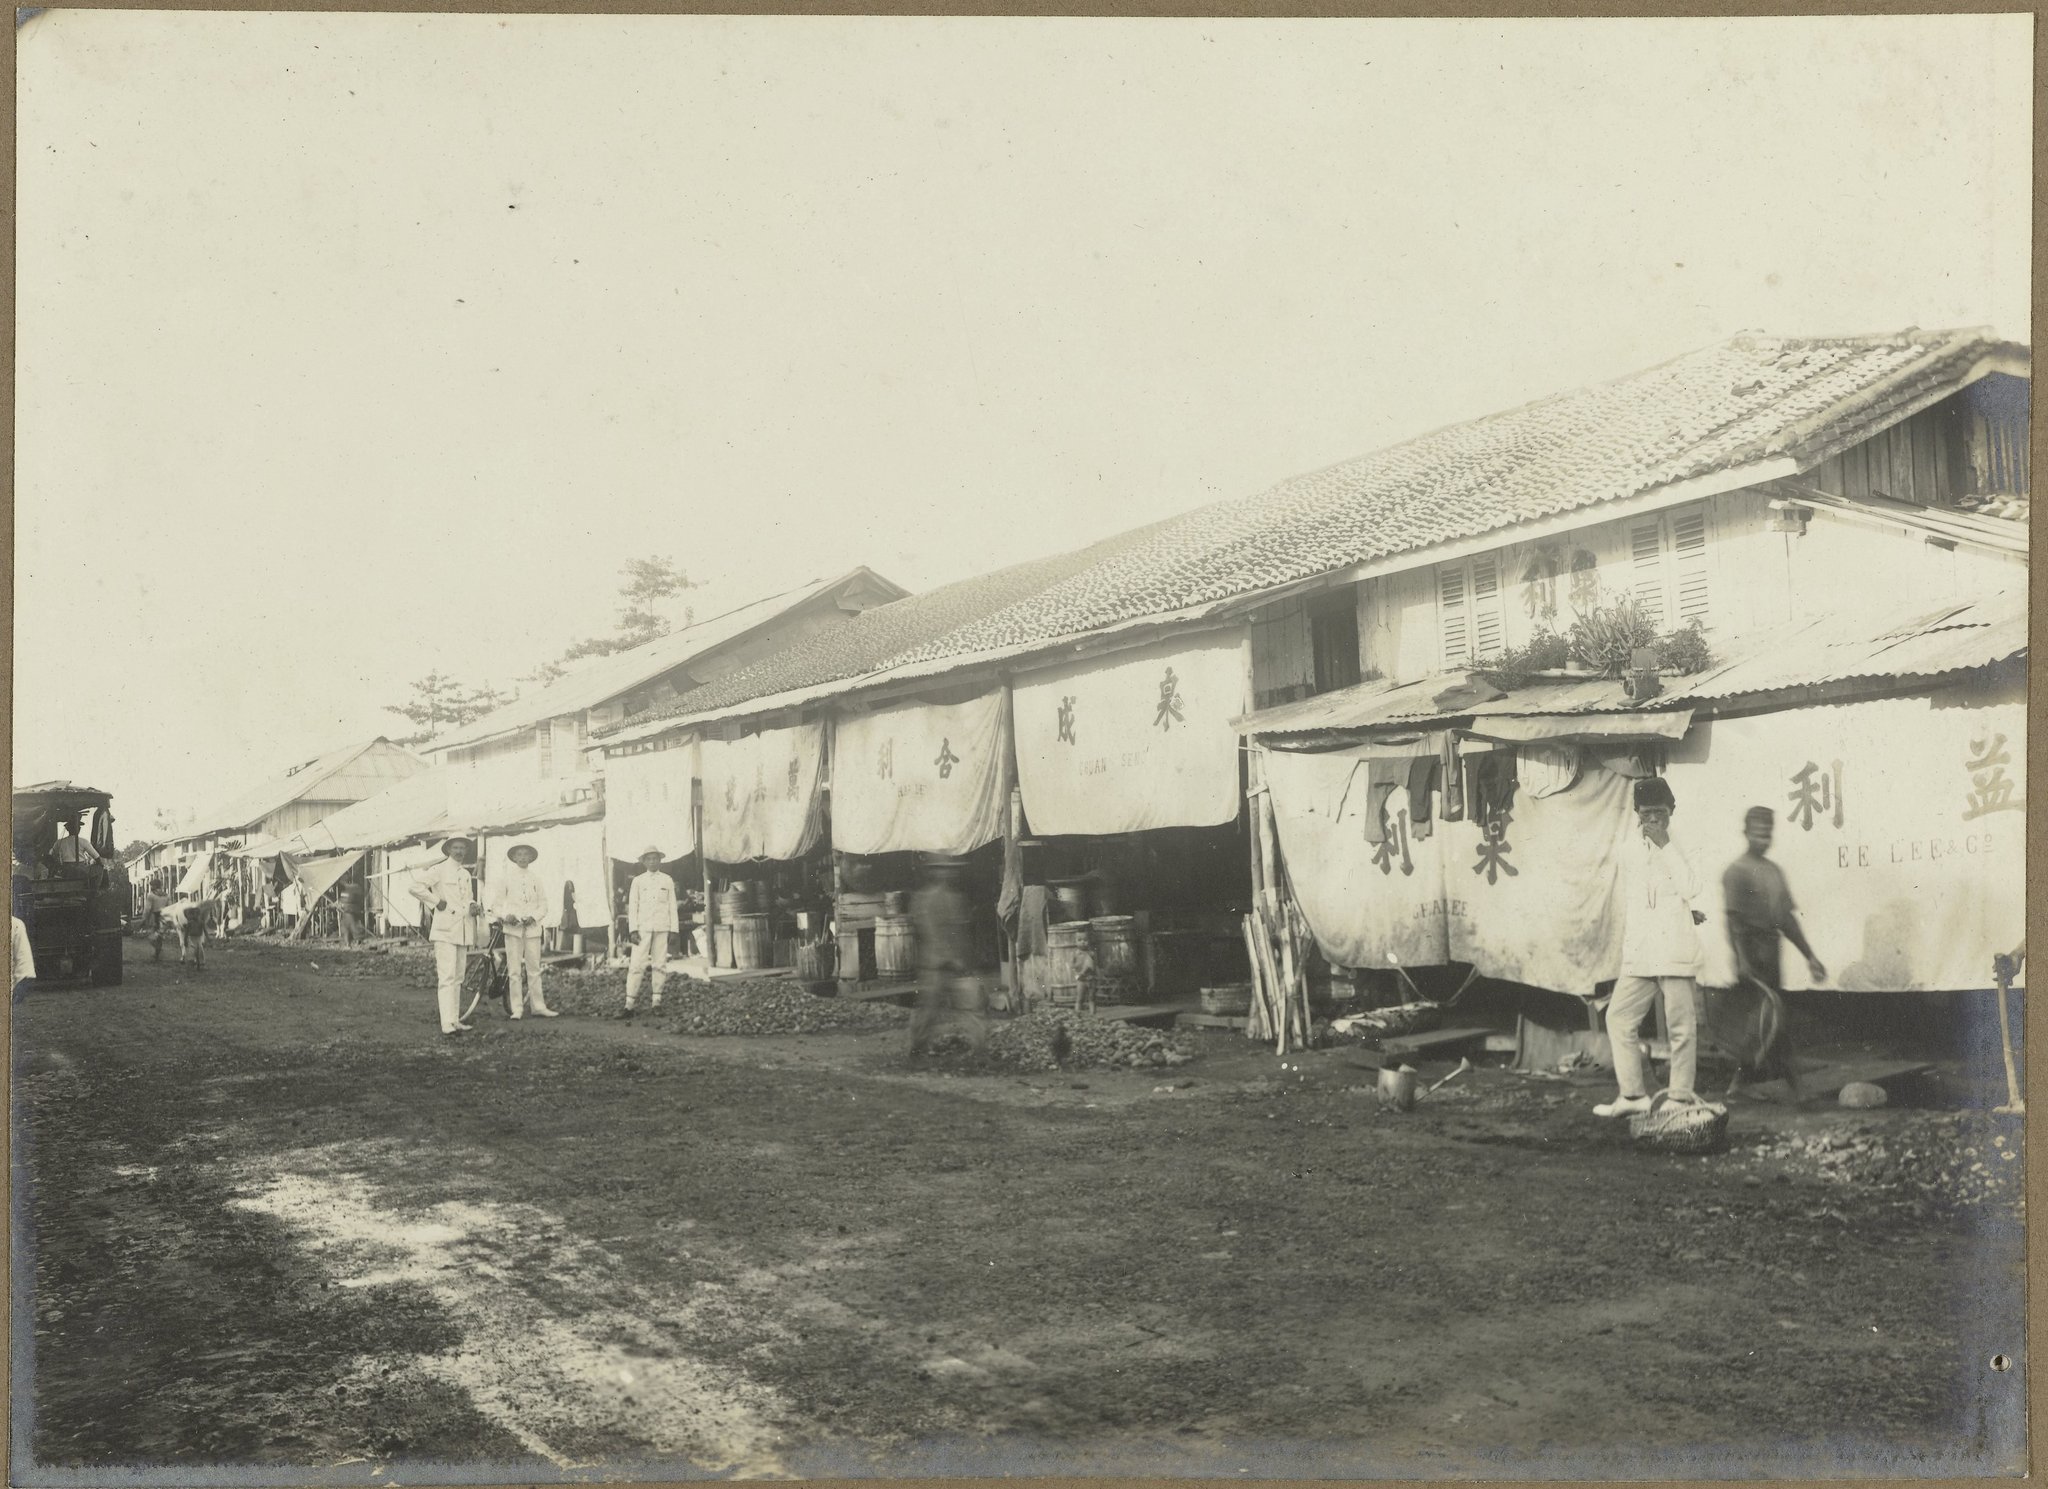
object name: photograph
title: Bennink en Riphagen in een straat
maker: Anonymous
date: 1914-1919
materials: photographic support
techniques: gelatin silver print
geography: medan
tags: architect in non-work situation, representation of real building (either existing or having existed), public road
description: Bennink en Riphagen poserend in een straat, waarschijnlijk te Medan. Rechts een Chinees bedrijf. Foto in het fotoalbum van het Nederlandse architectenbureau en aannemersbedrijf Bennink en Riphagen te Medan in de jaren ca. 1914-1919.